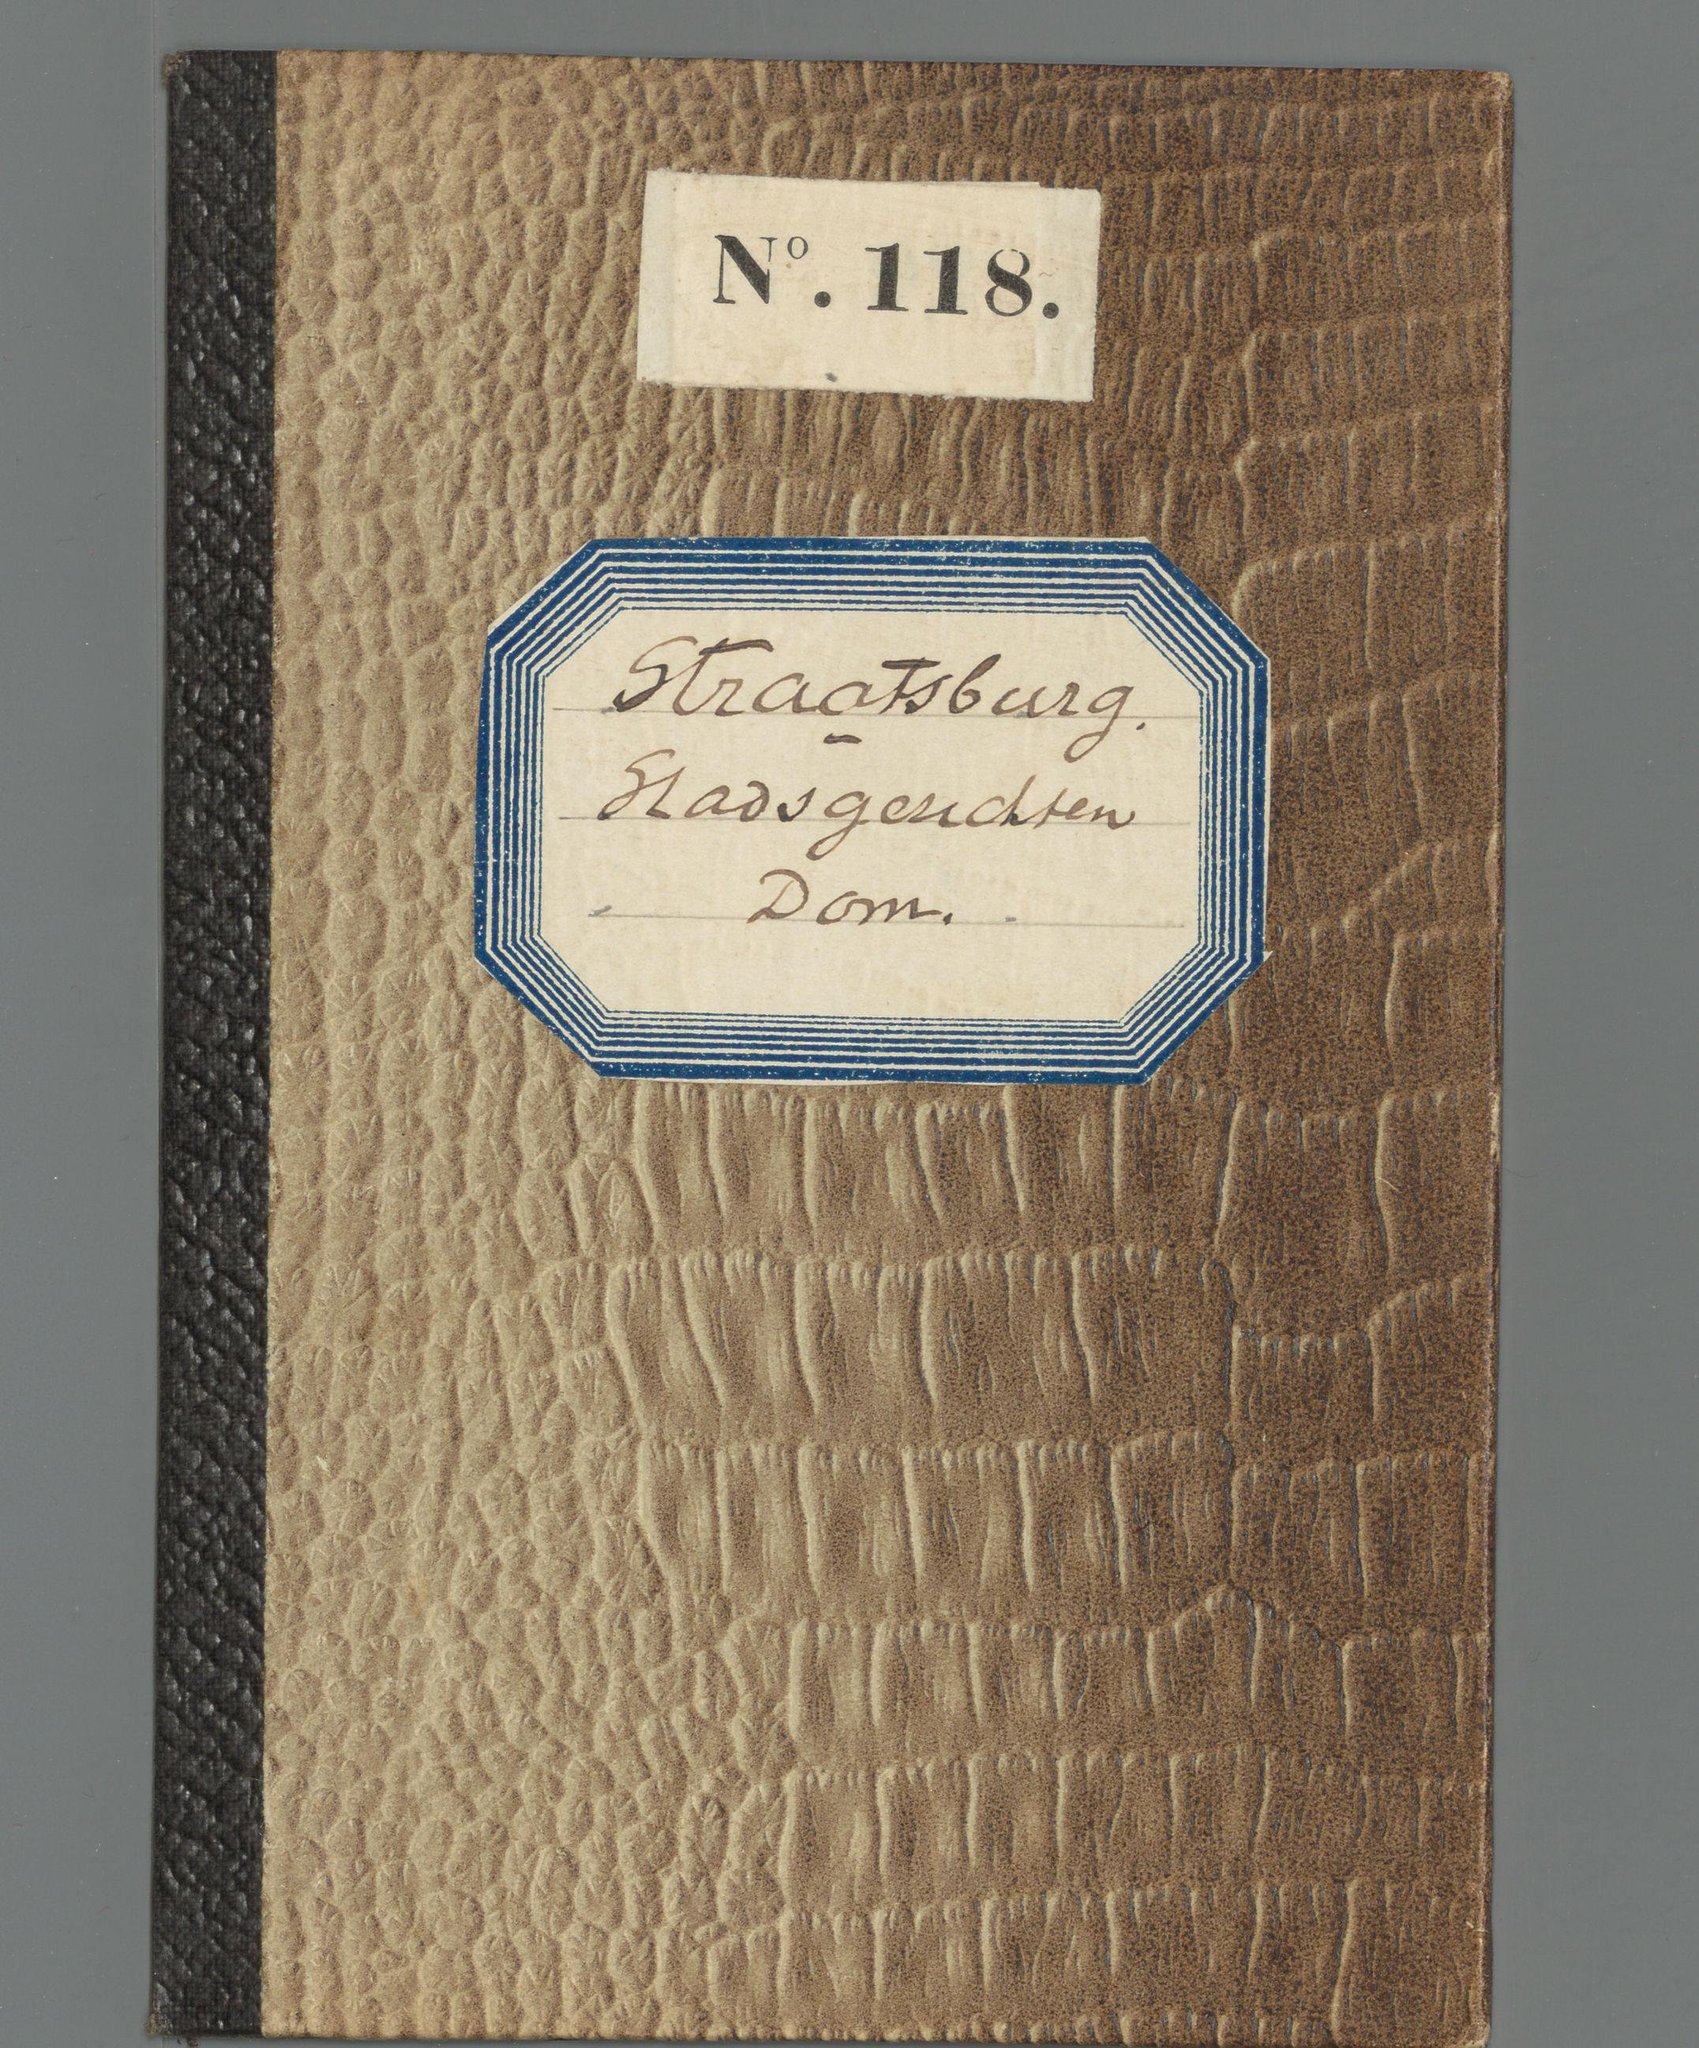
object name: wrapper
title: Omslag voor acht prentbriefkaarten met stadsgezichten uit Straatsburg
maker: Anonymous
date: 1900-1950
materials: cardboard, paper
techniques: lithograph, writing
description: In de omslag zit een kaart ingestoken met daarop een korte beschrijving van de inhoud.